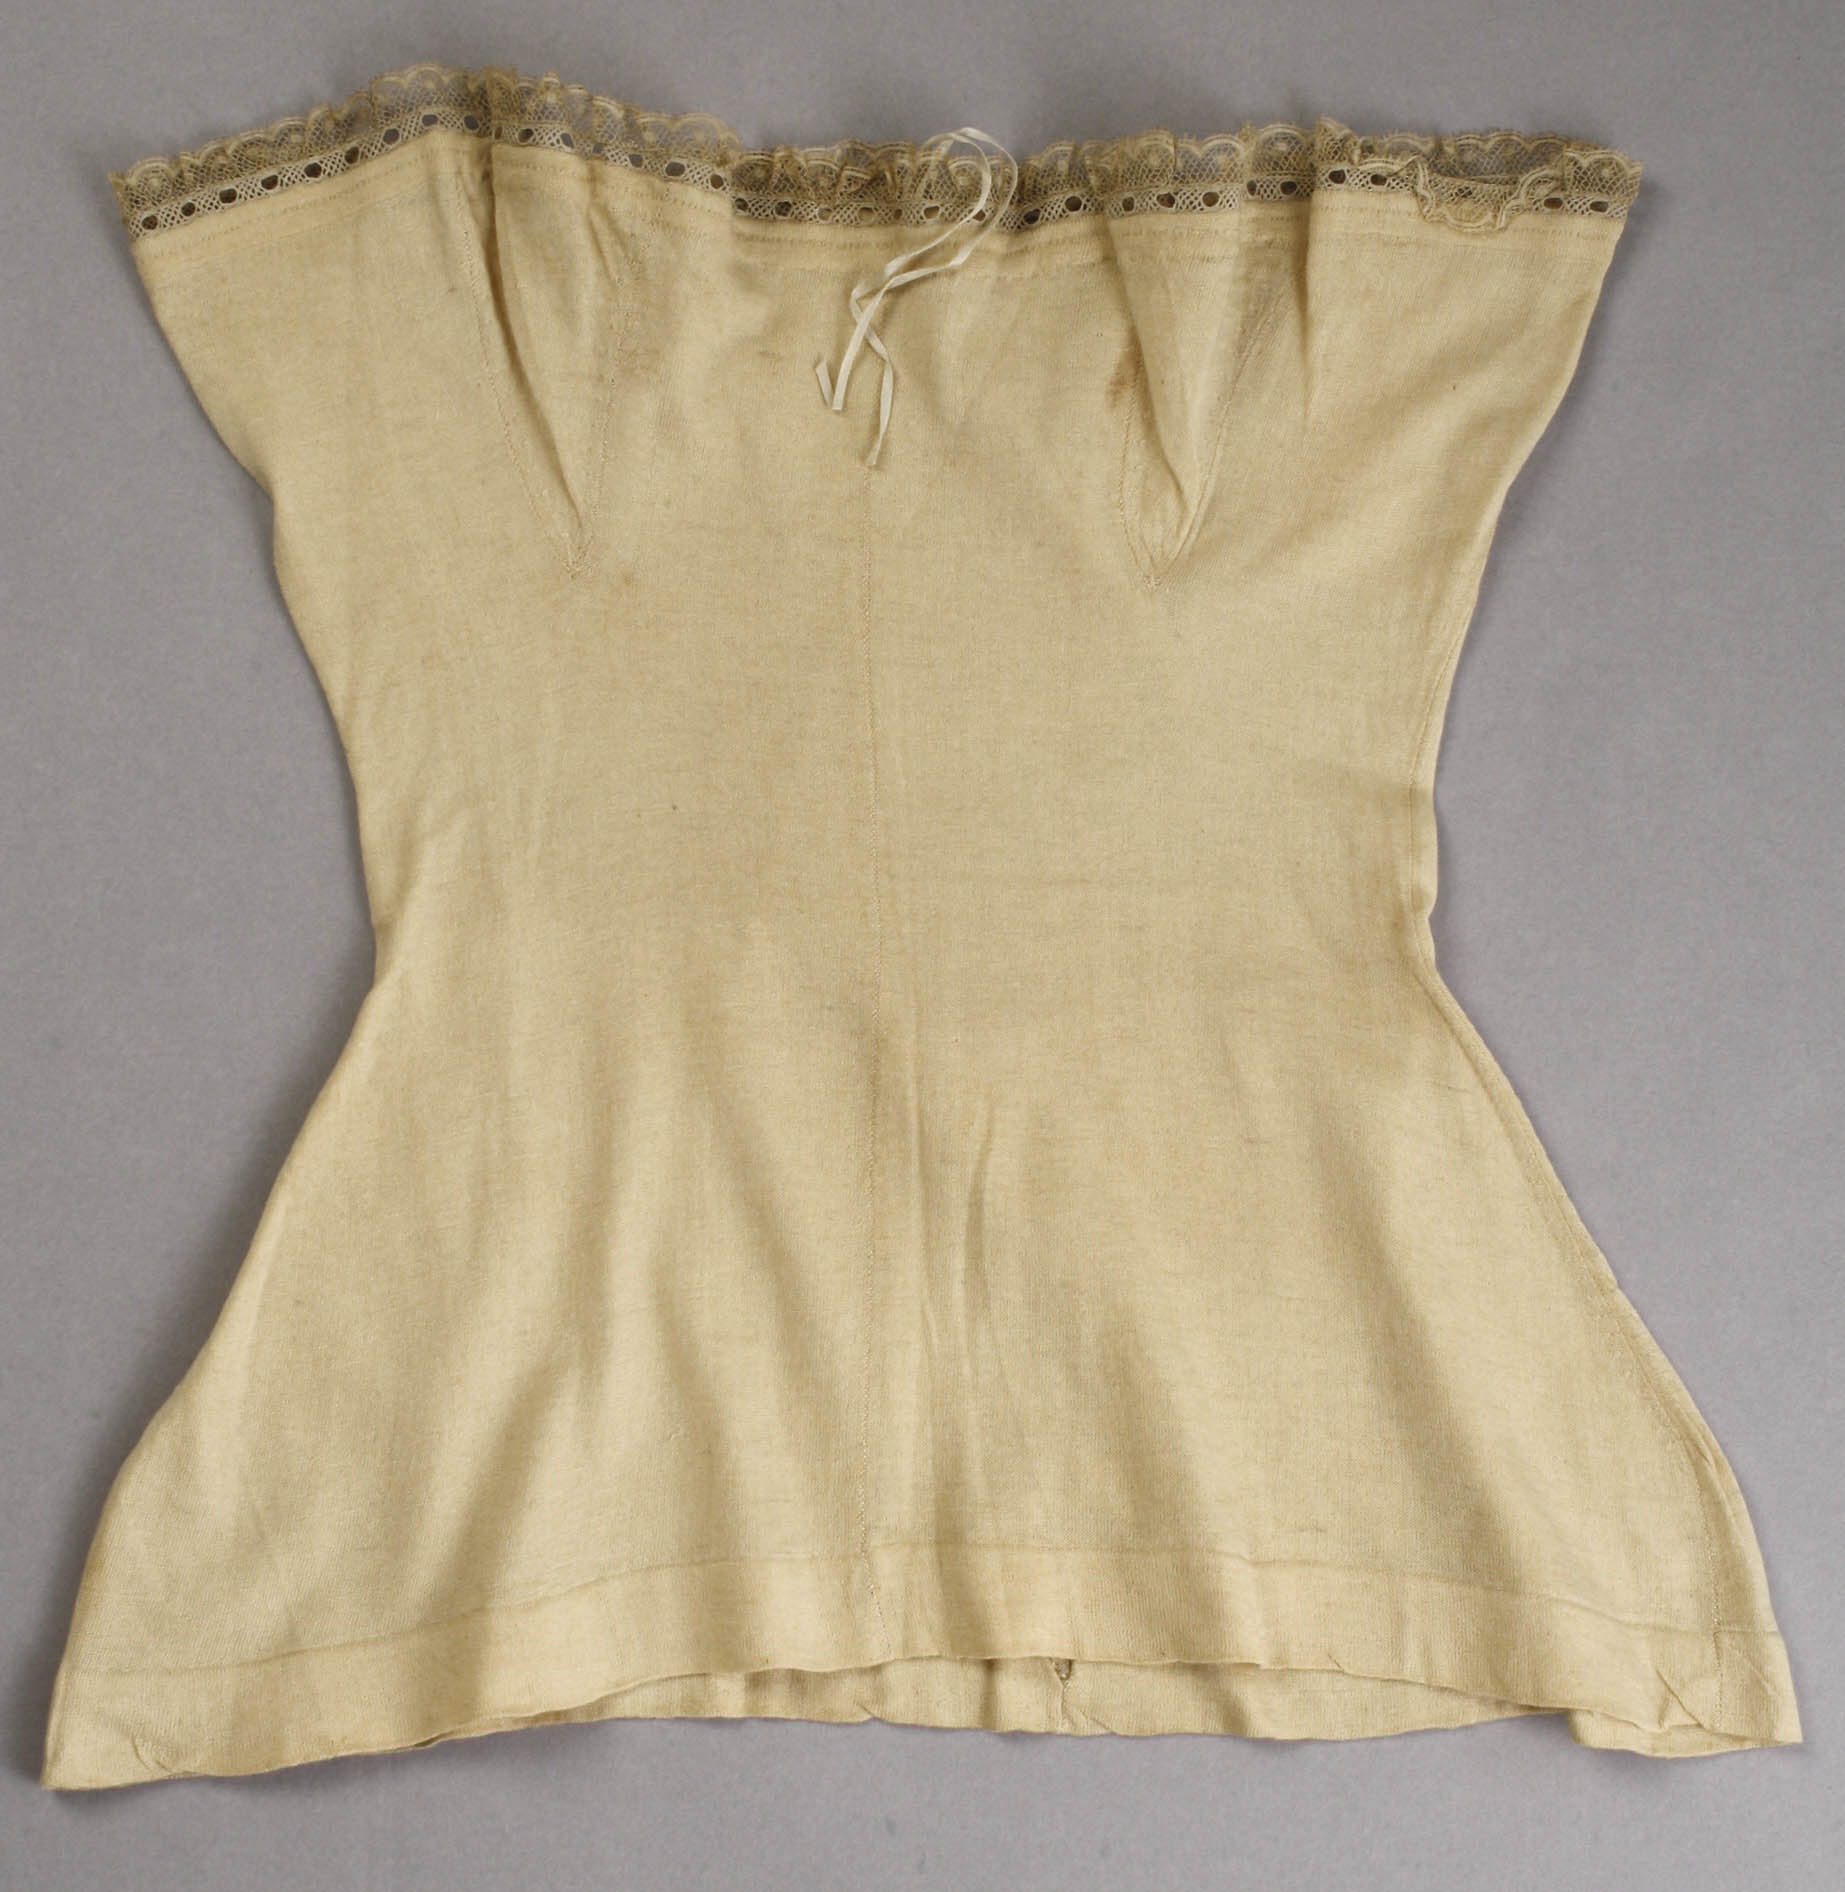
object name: undershirt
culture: american or european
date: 1880-1889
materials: wool